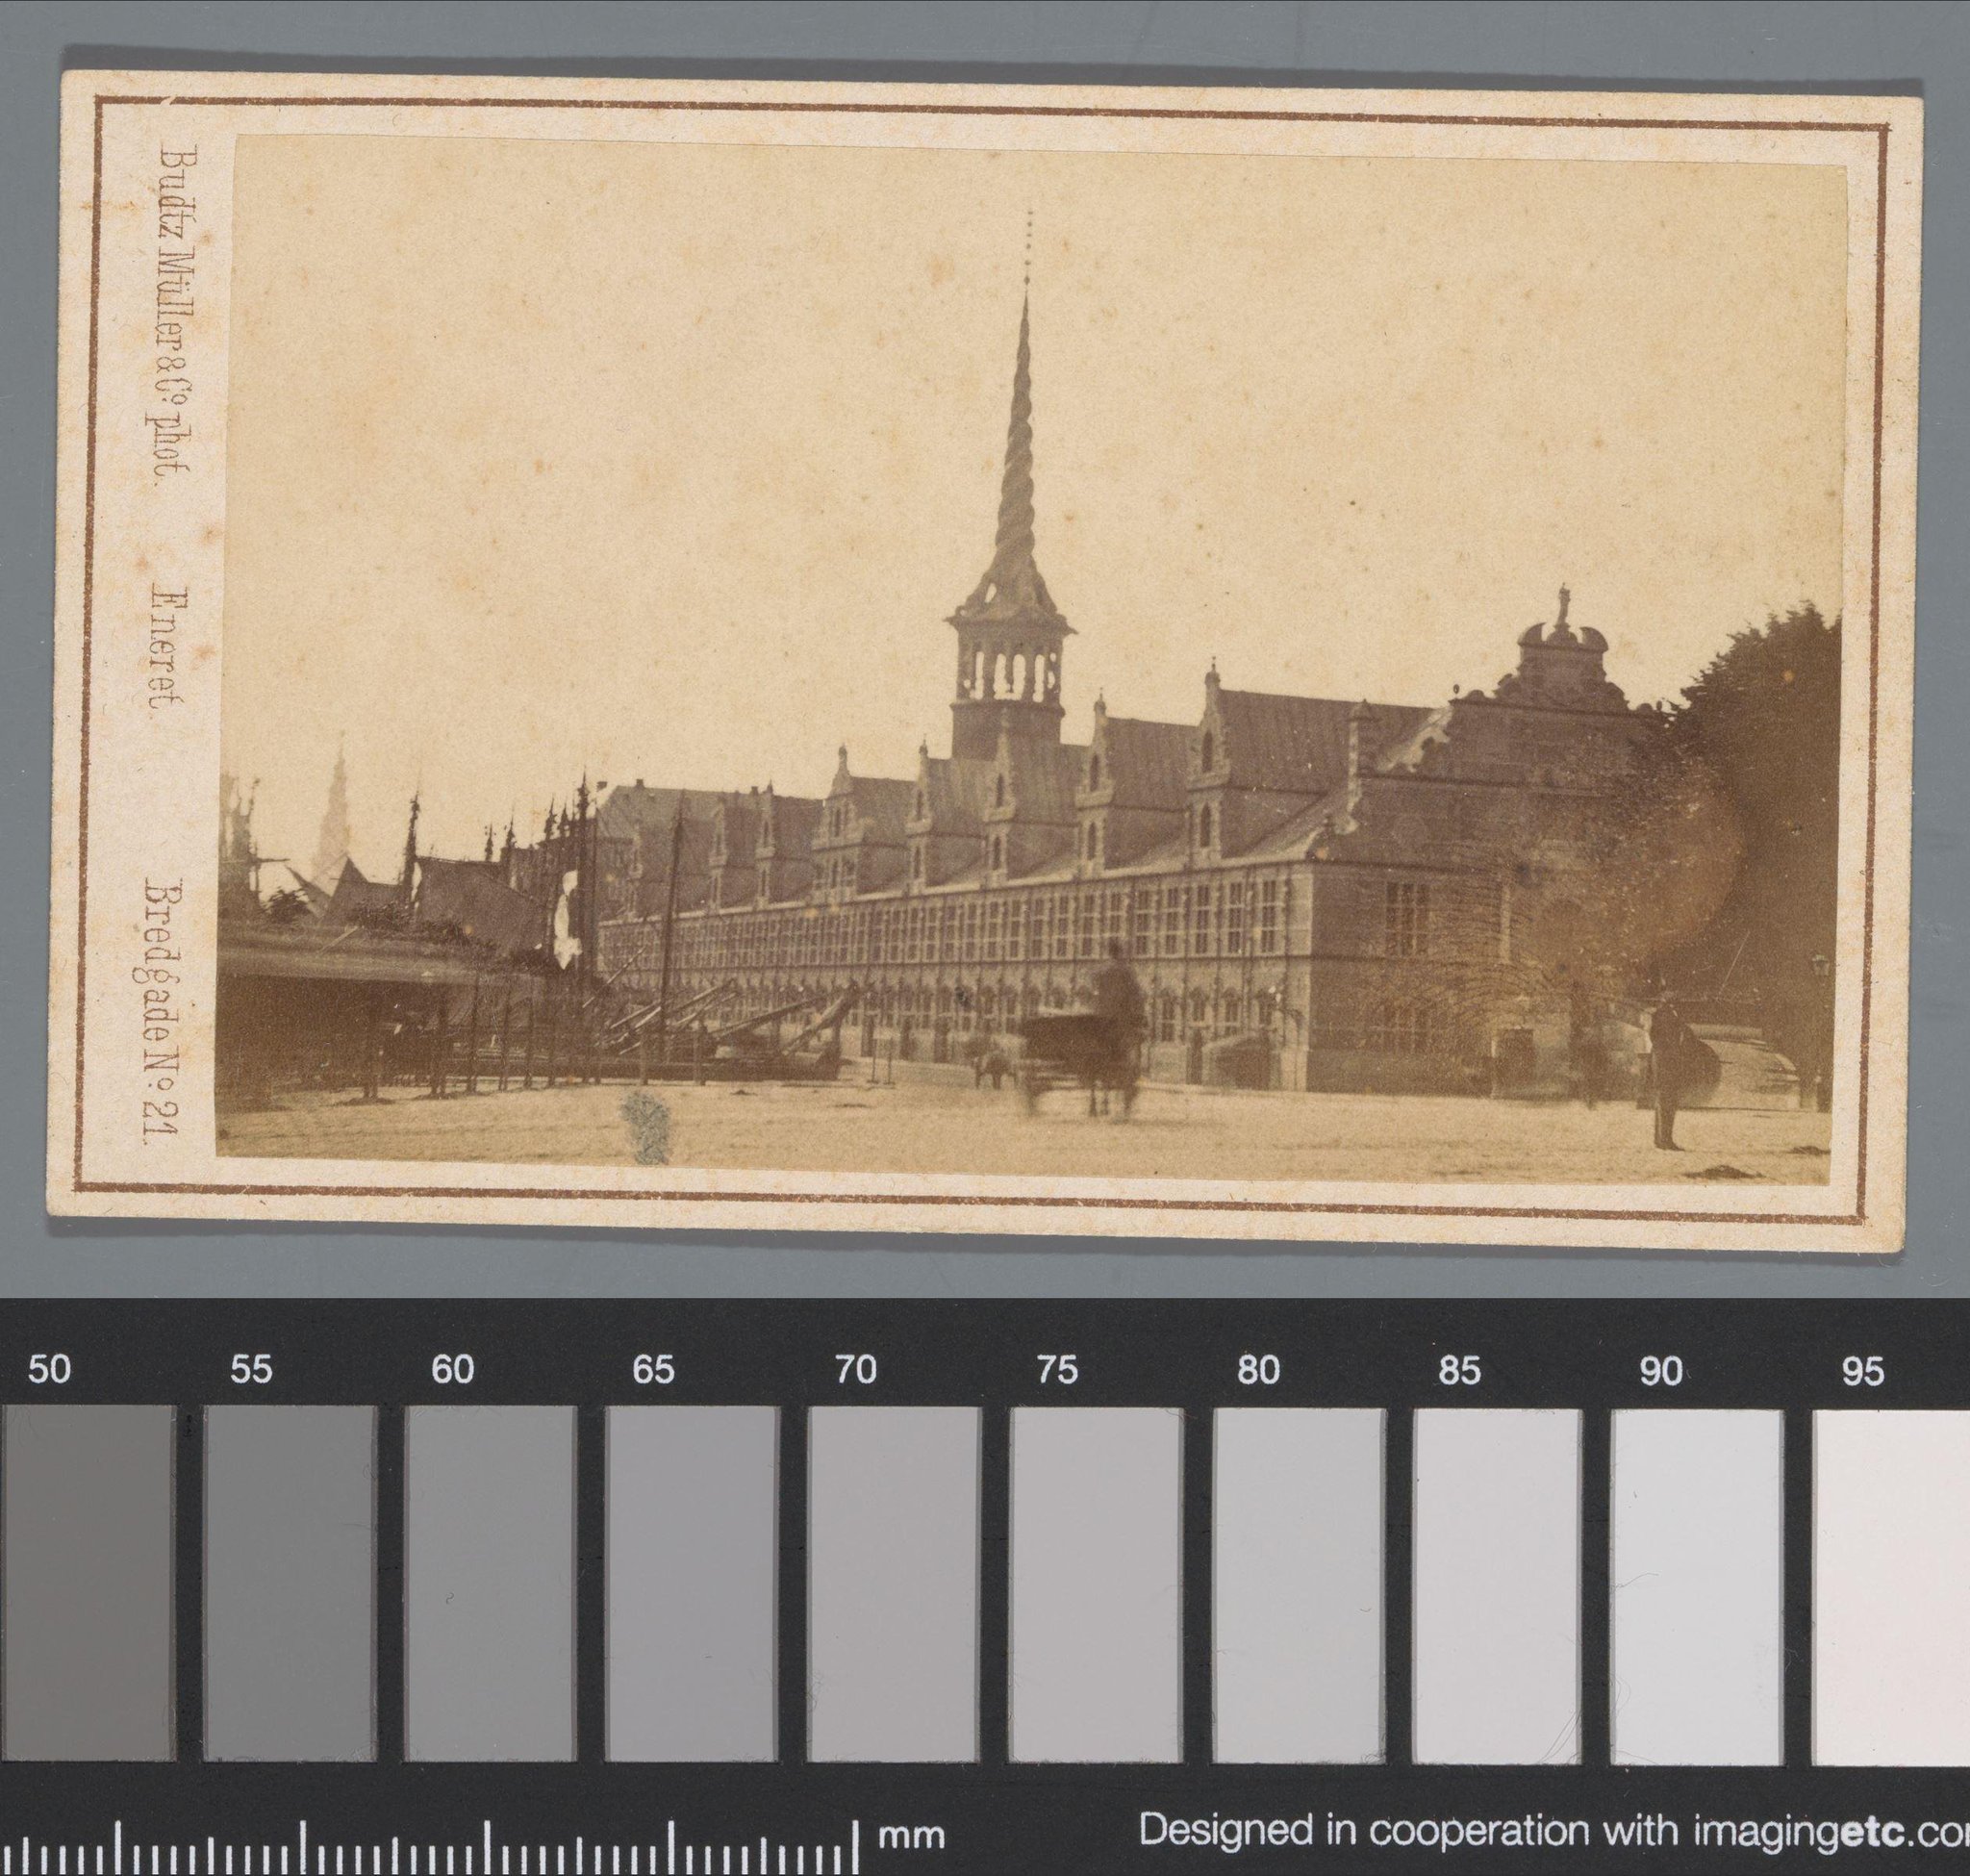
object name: photograph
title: Kopenhagen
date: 1862-1904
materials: cardboard, paper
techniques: albumen print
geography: copenhagen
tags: stock exchange, stock-market, parts of church exterior and annexes: spire, copenhagen (city)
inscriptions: inscription: ‘Khl. Dansk, Svensk og Norsk Hof-Fotograf/ Fotogr. Atelier/ ved/ Budtz Müller & Co./ Bredgade 21 Norgesgade/ Kiöbenhavn.’, inscription: ‘Eneret.’